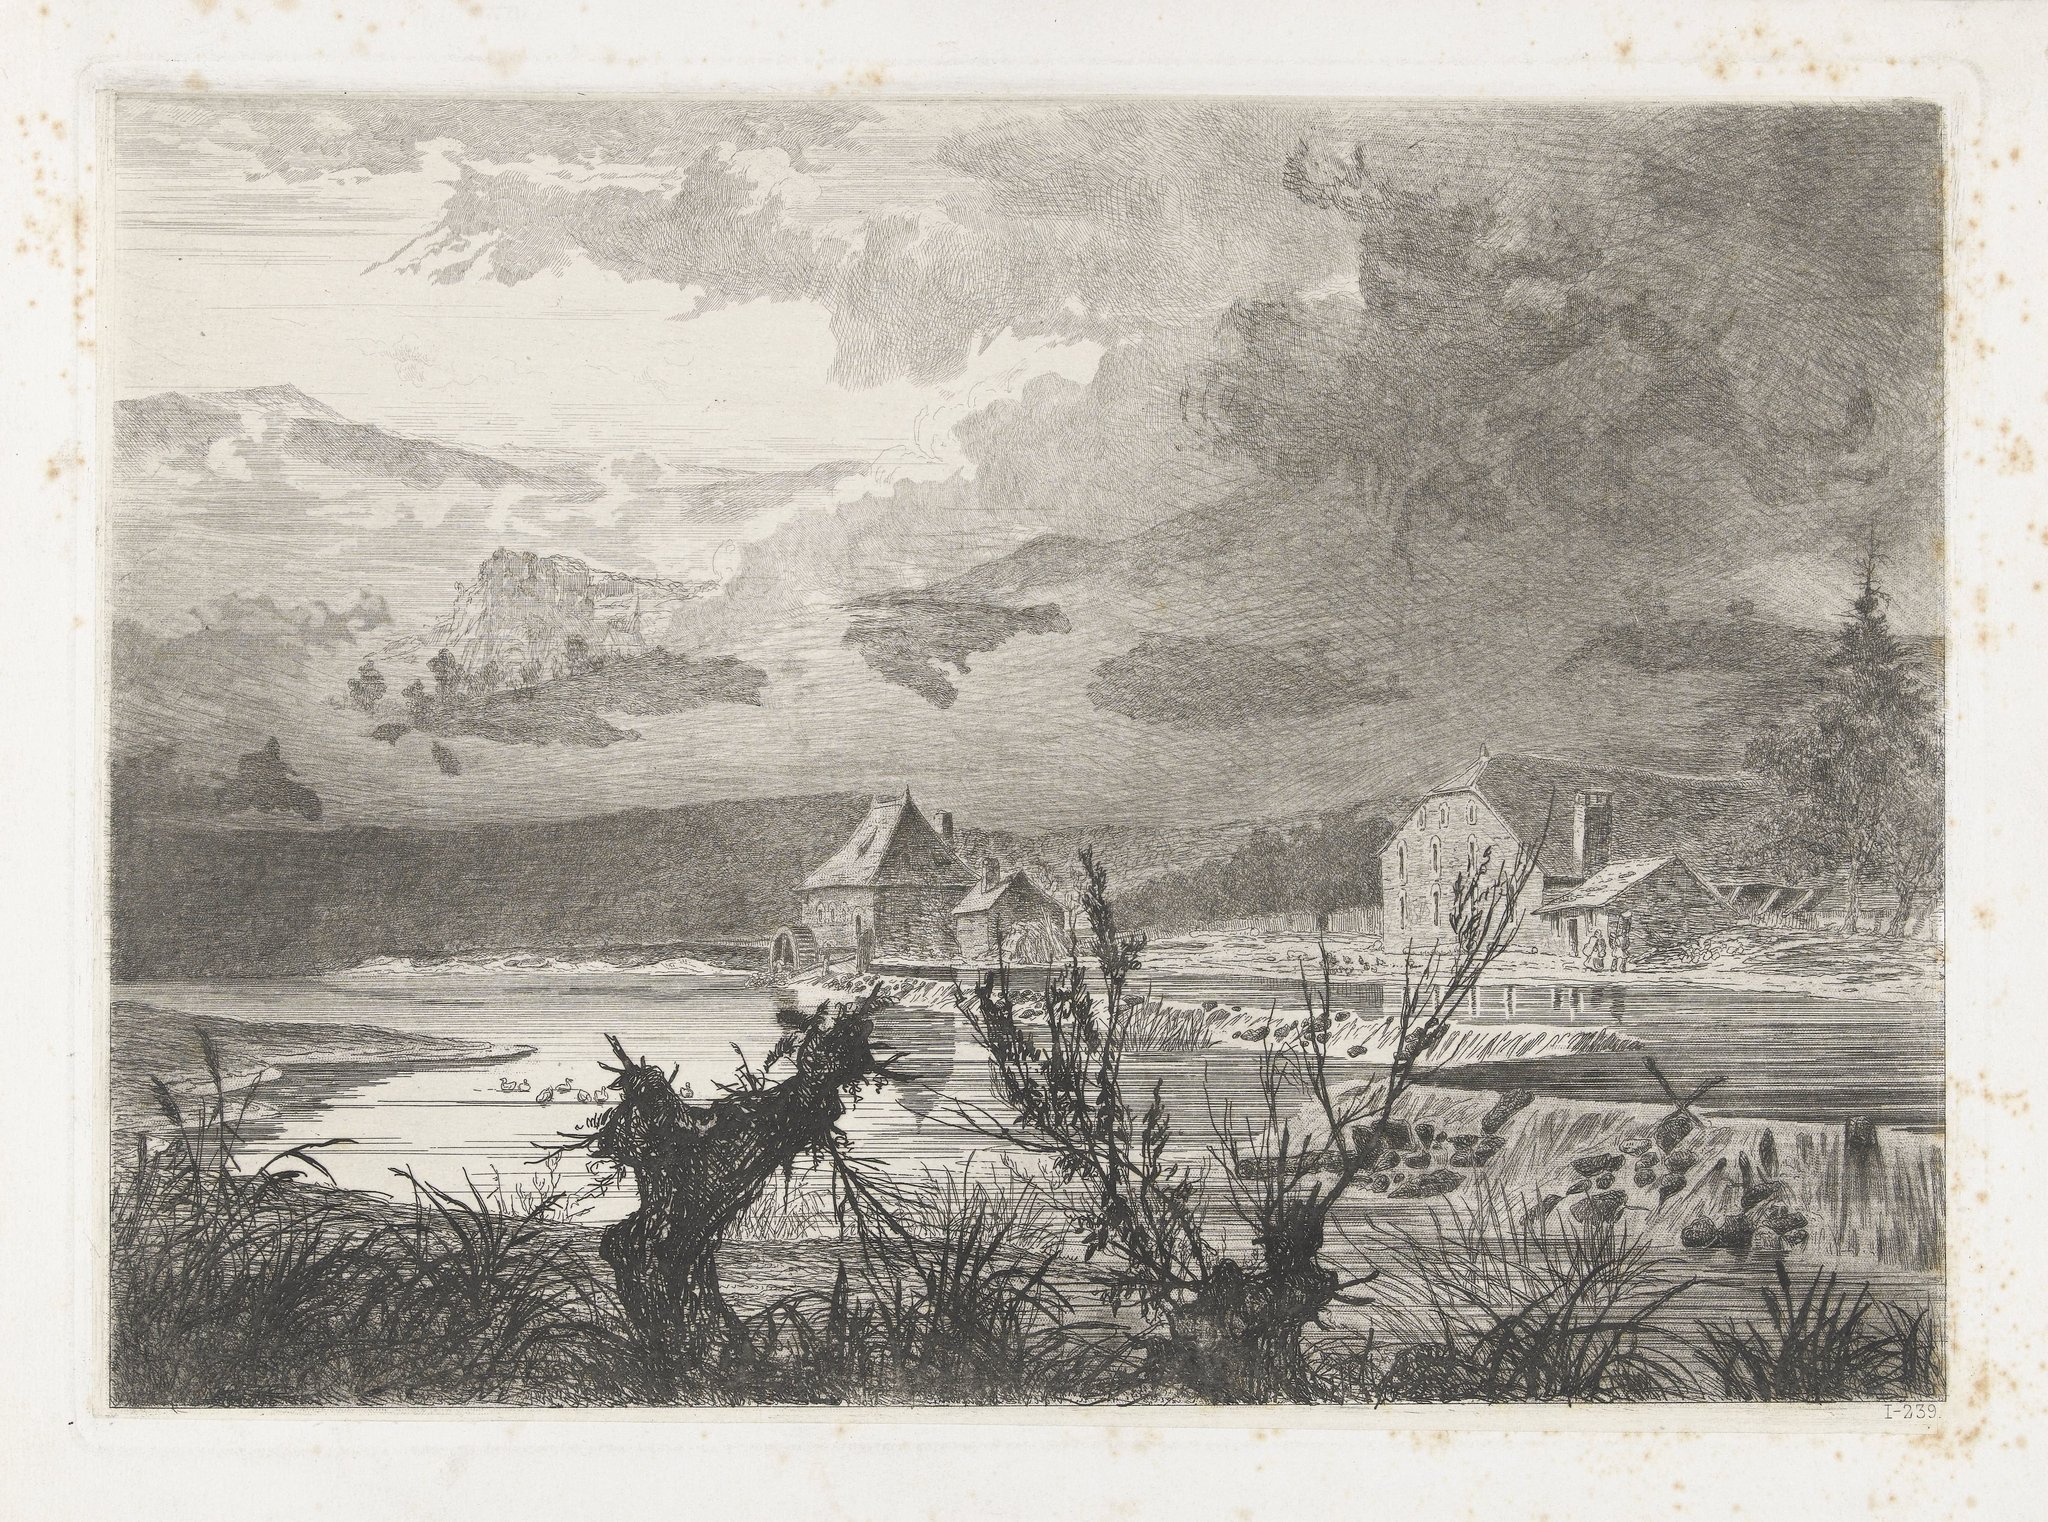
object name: print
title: Molen en boerderij aan de rivier de Semoy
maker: martinus antonius kuytenbrouwer jr.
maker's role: draughtsman, painter, print maker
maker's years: 1821-1897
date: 1850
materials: paper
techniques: drypoint, etching, intaglio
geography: brussels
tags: low hill country, river, farmers - aa - female farmer, farmer's wife, watermill in landscape, farm or solitary house in landscape, water-birds: duck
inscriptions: collector's mark: Lugt 2228, collector's mark: Lugt 1485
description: In een heuvelachtig landschap liggen een boerenhuis en een watermolen aan de rivier de Semoy. In de rivier zwemmen enkele eenden en rechts lopen een man en een vrouw langs de waterkant.